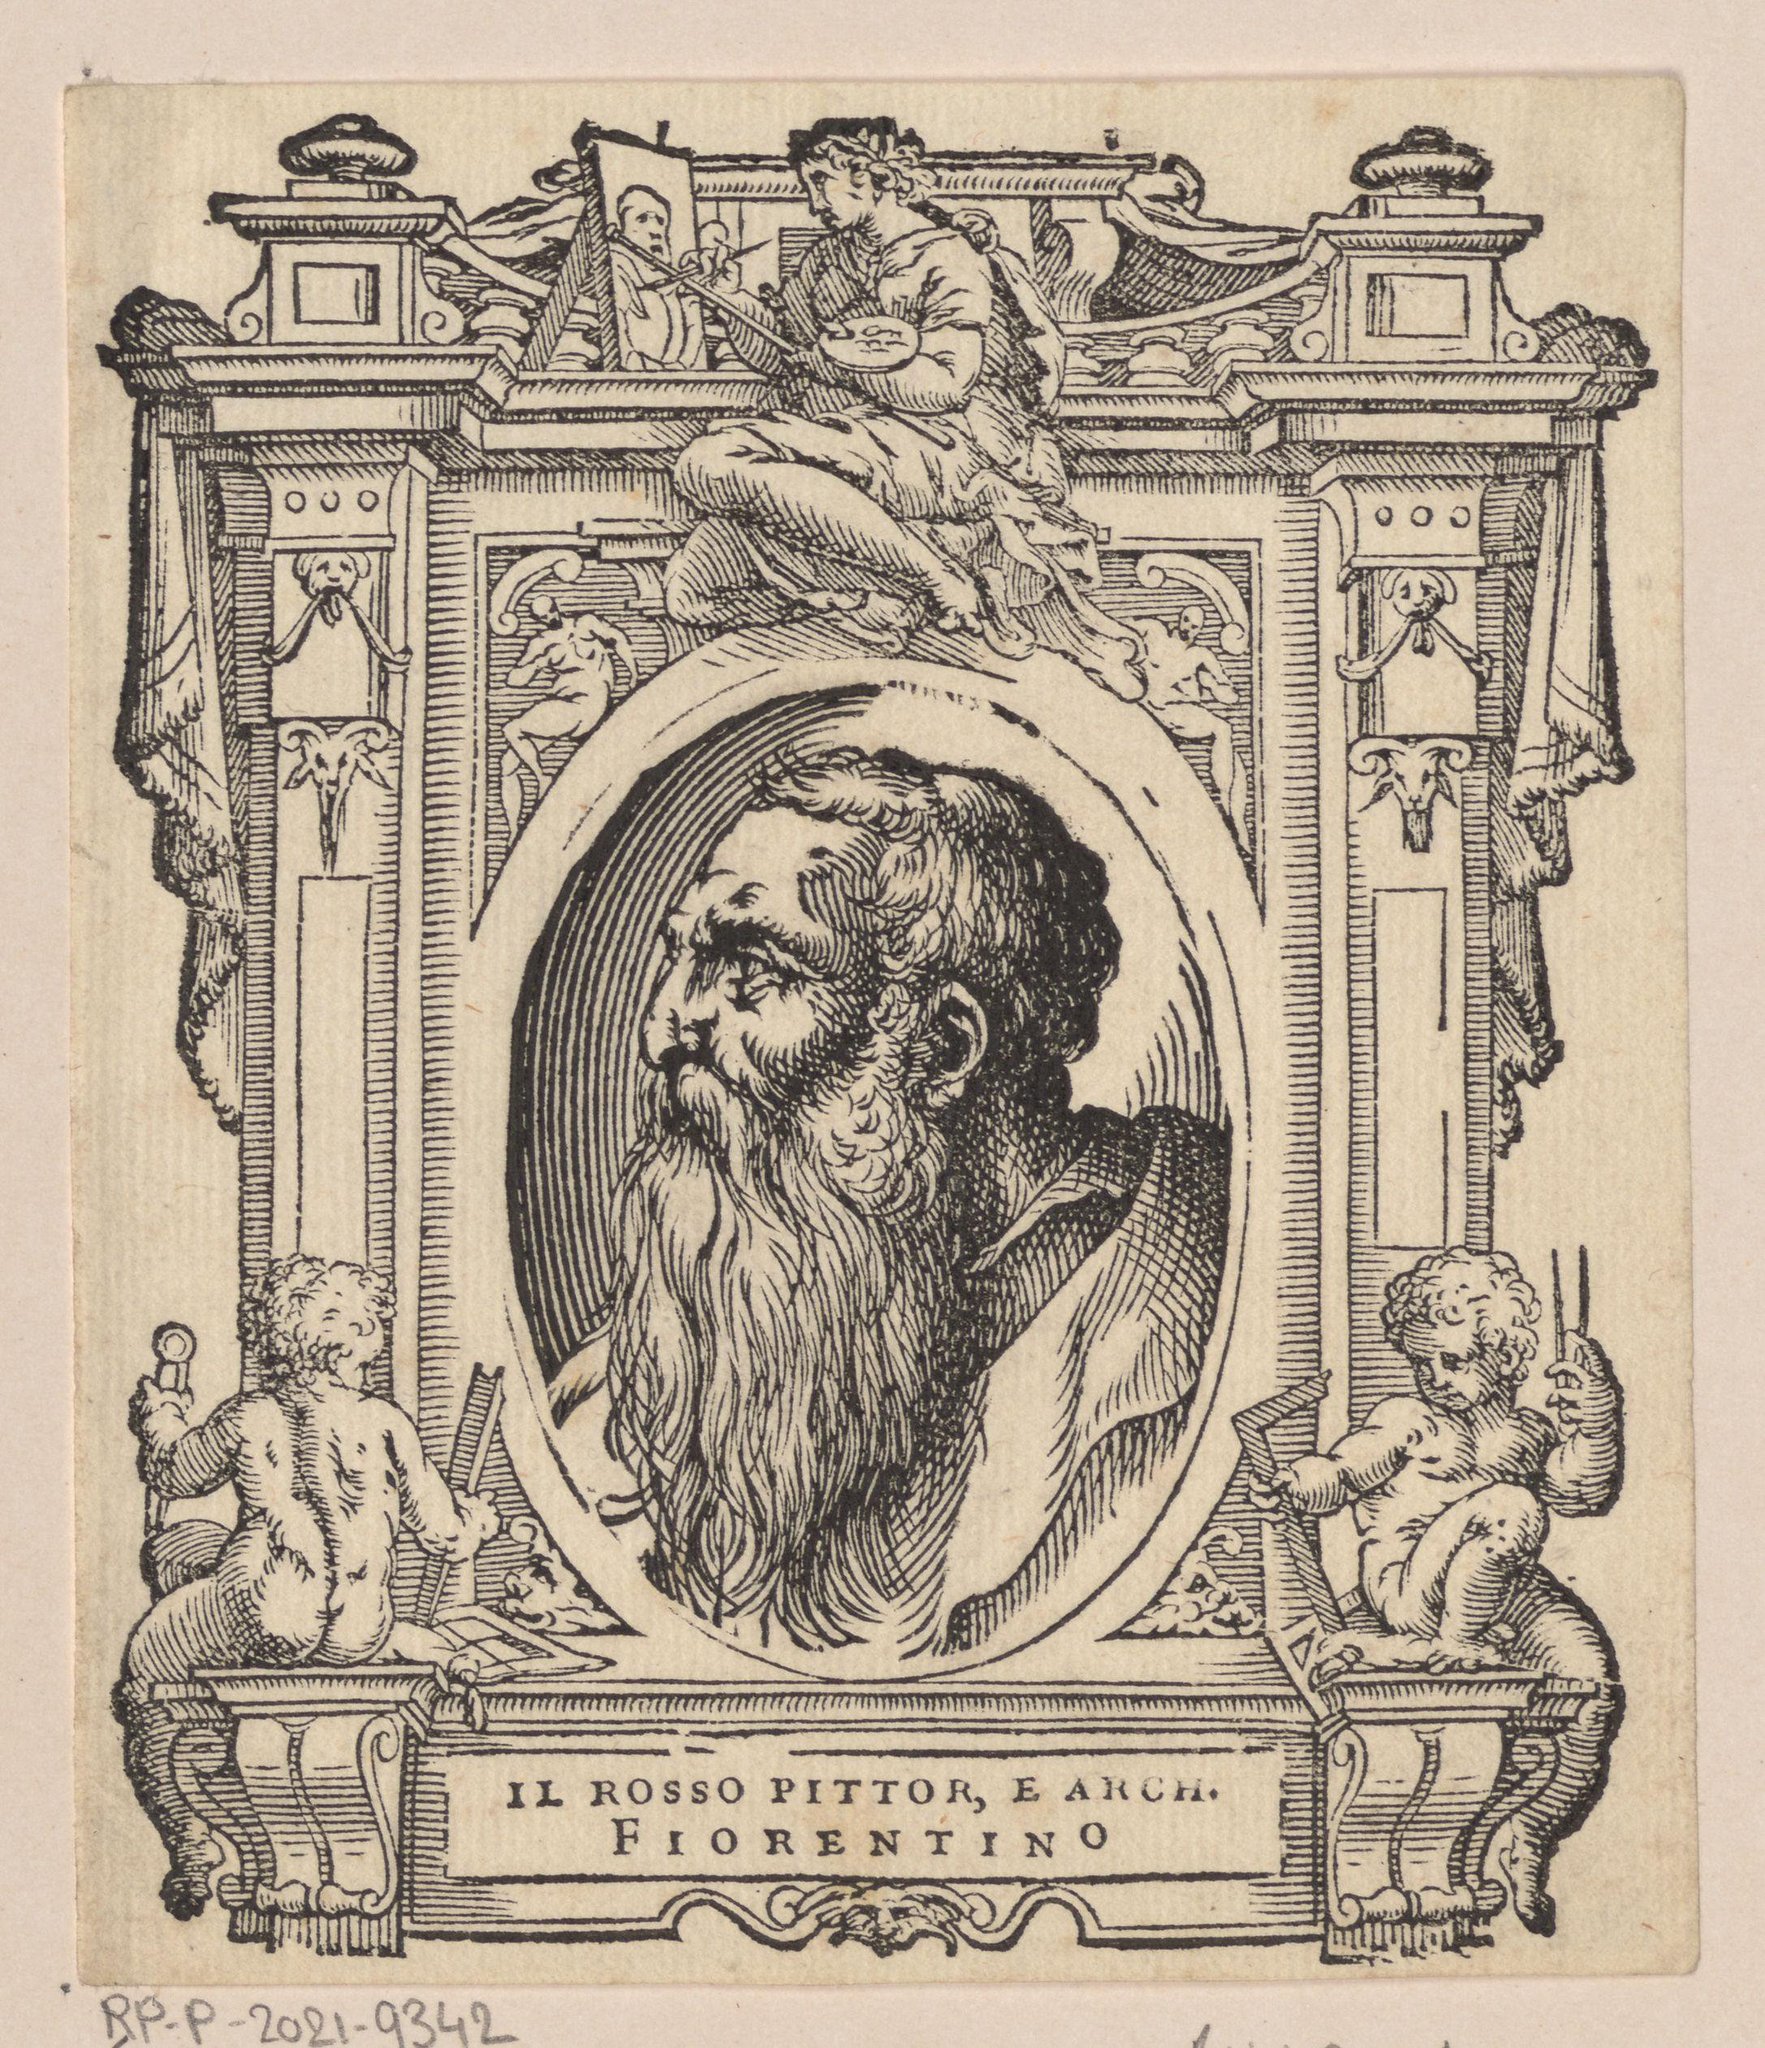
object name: print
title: Portret van Rosso Fiorentino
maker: Anonymous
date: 1568-1647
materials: paper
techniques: letterpress printing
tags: painter, print maker, draughtsman, rosso fiorentino, historical persons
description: Prent komt uit een editie van Vasari's 'Vite'. Prent met een andere omlijsting gebruikt in: Vasari, Giorgio. Le vite de' piu eccellenti pittori scultori, e architettori. Florence: Filippo Giunta, 1568. En in de editie uit 1647.